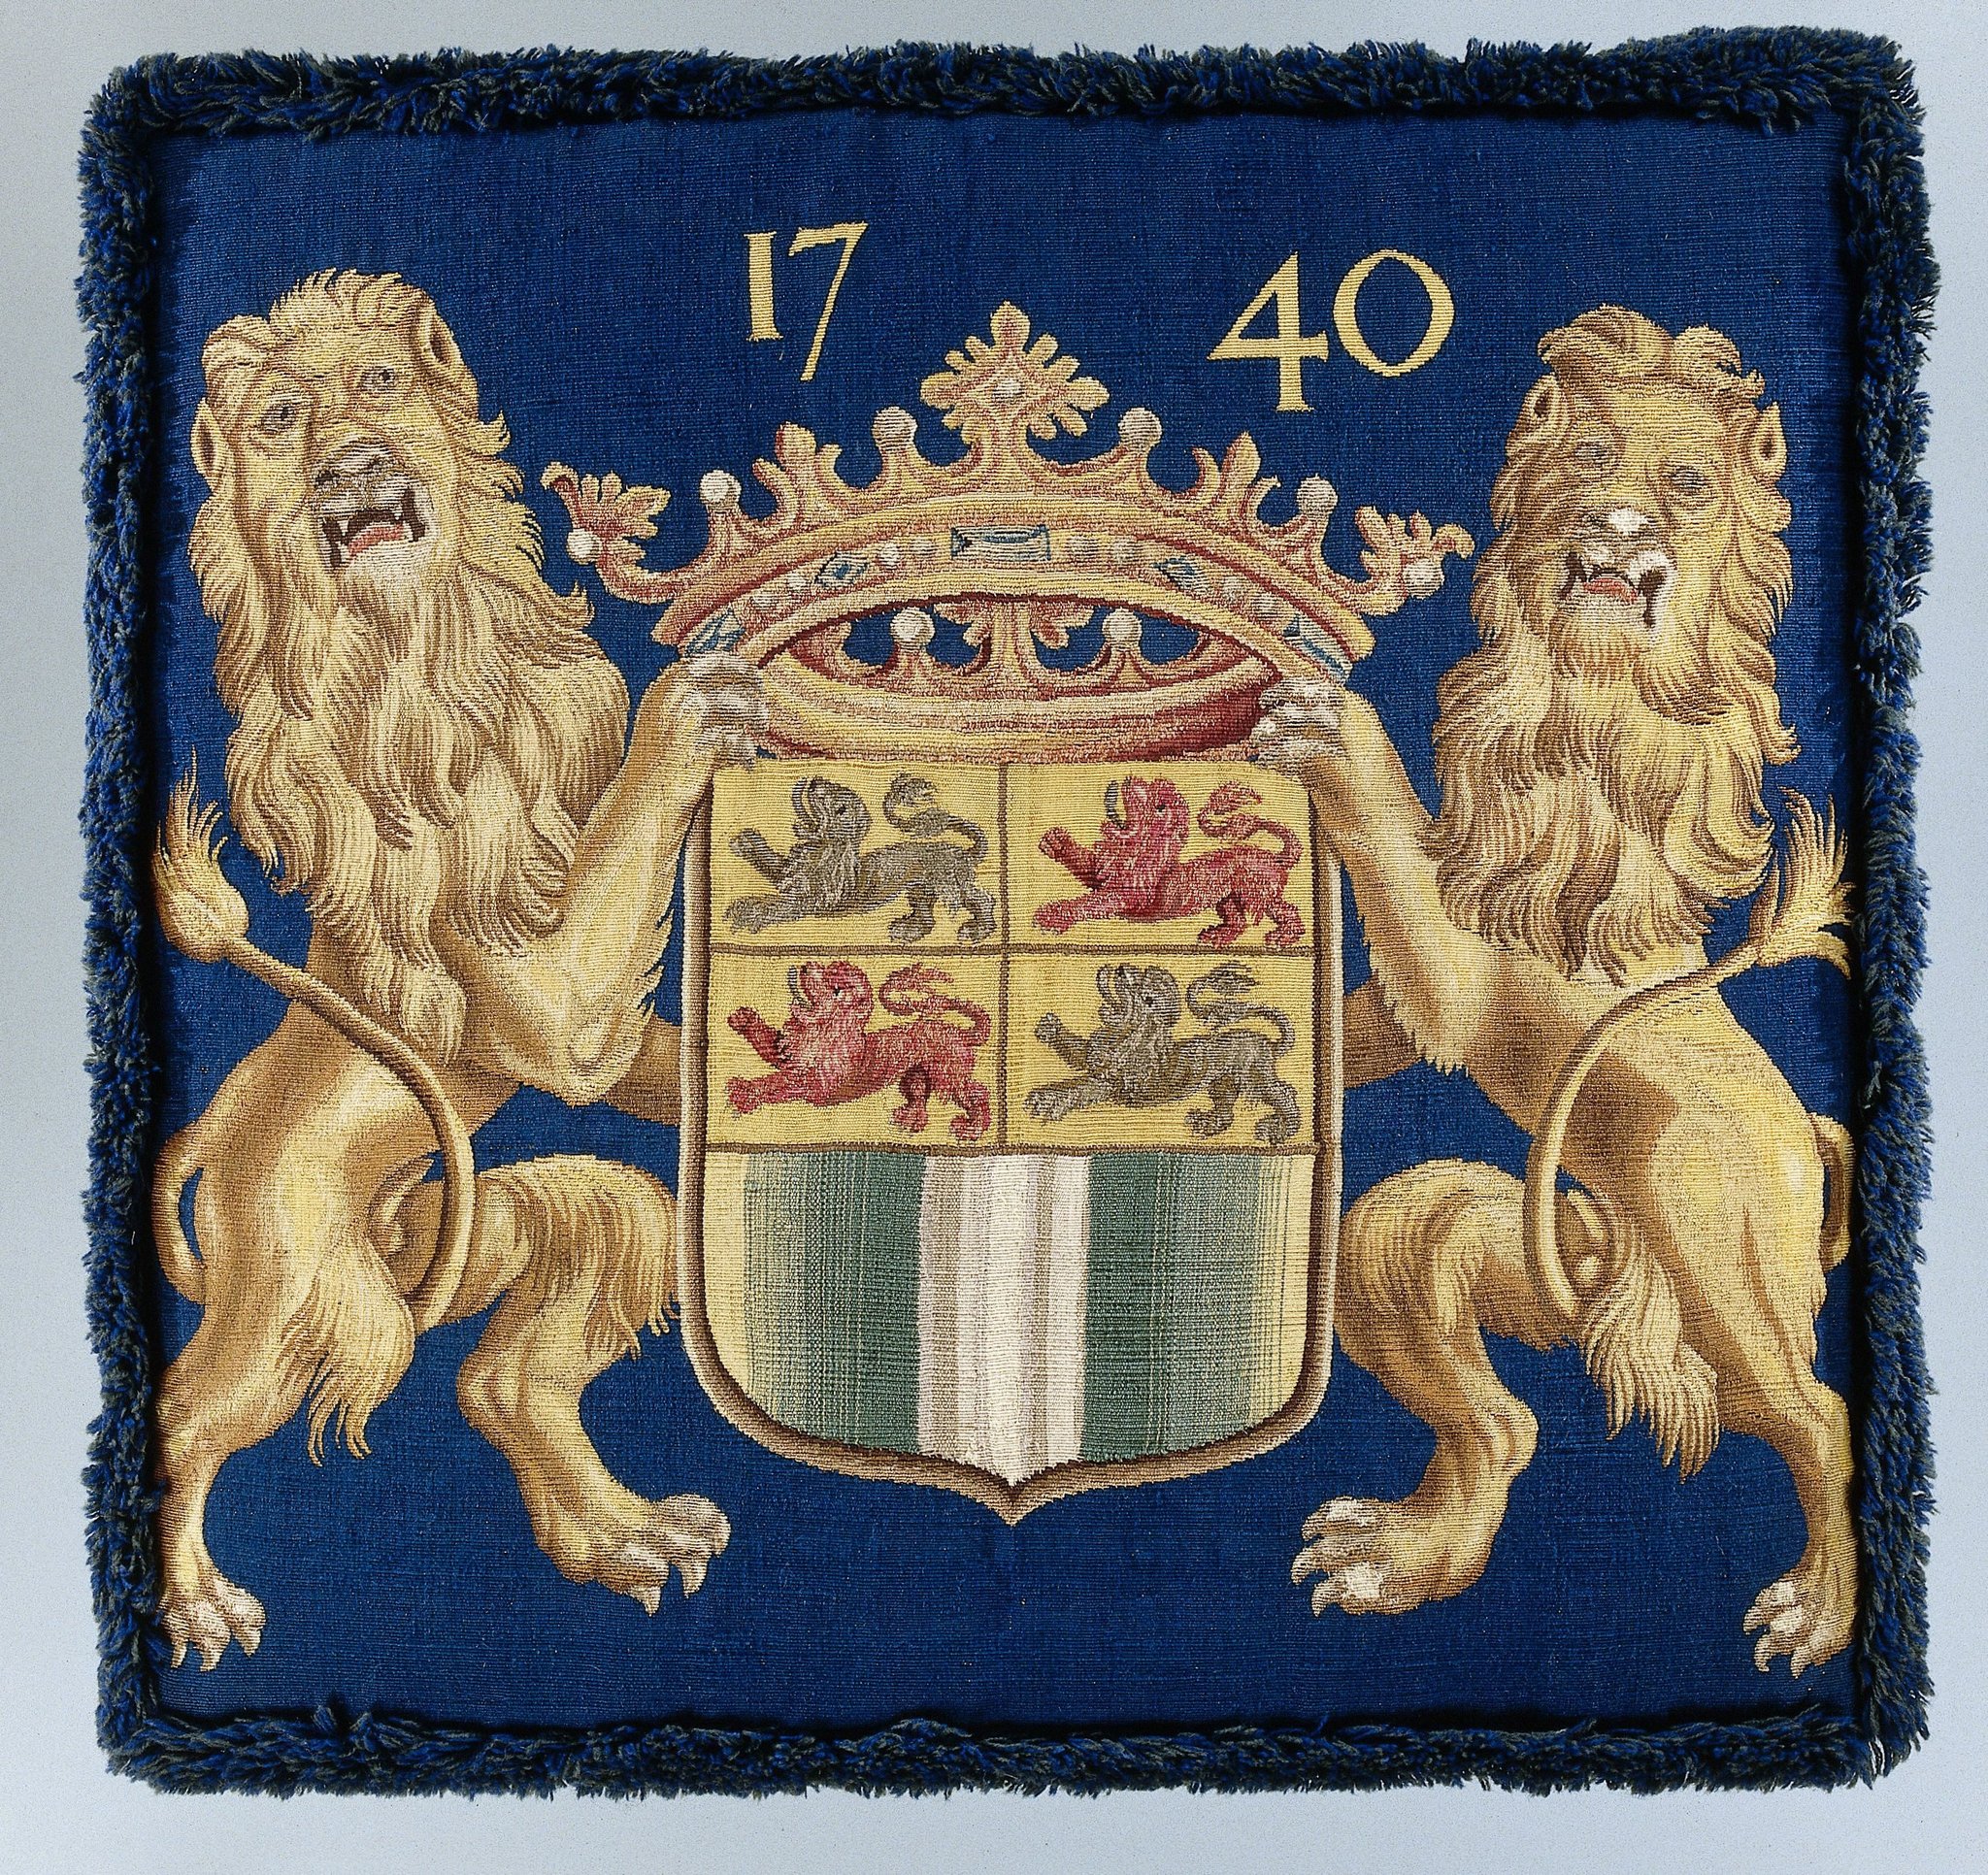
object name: pillow sham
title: Kussenovertrek met het stadswapen van Rotterdam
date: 1740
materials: silk, wool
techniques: tapestry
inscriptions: date: ‘1740’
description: Kussenblad van een magistratenkussen van tapisserieweefsel. Tegen een blauwe grond het gekroonde wapen van Rotterdam, geflankeerd door twee klimmende leeuwen. Boven de kroon het jaartal 1740.